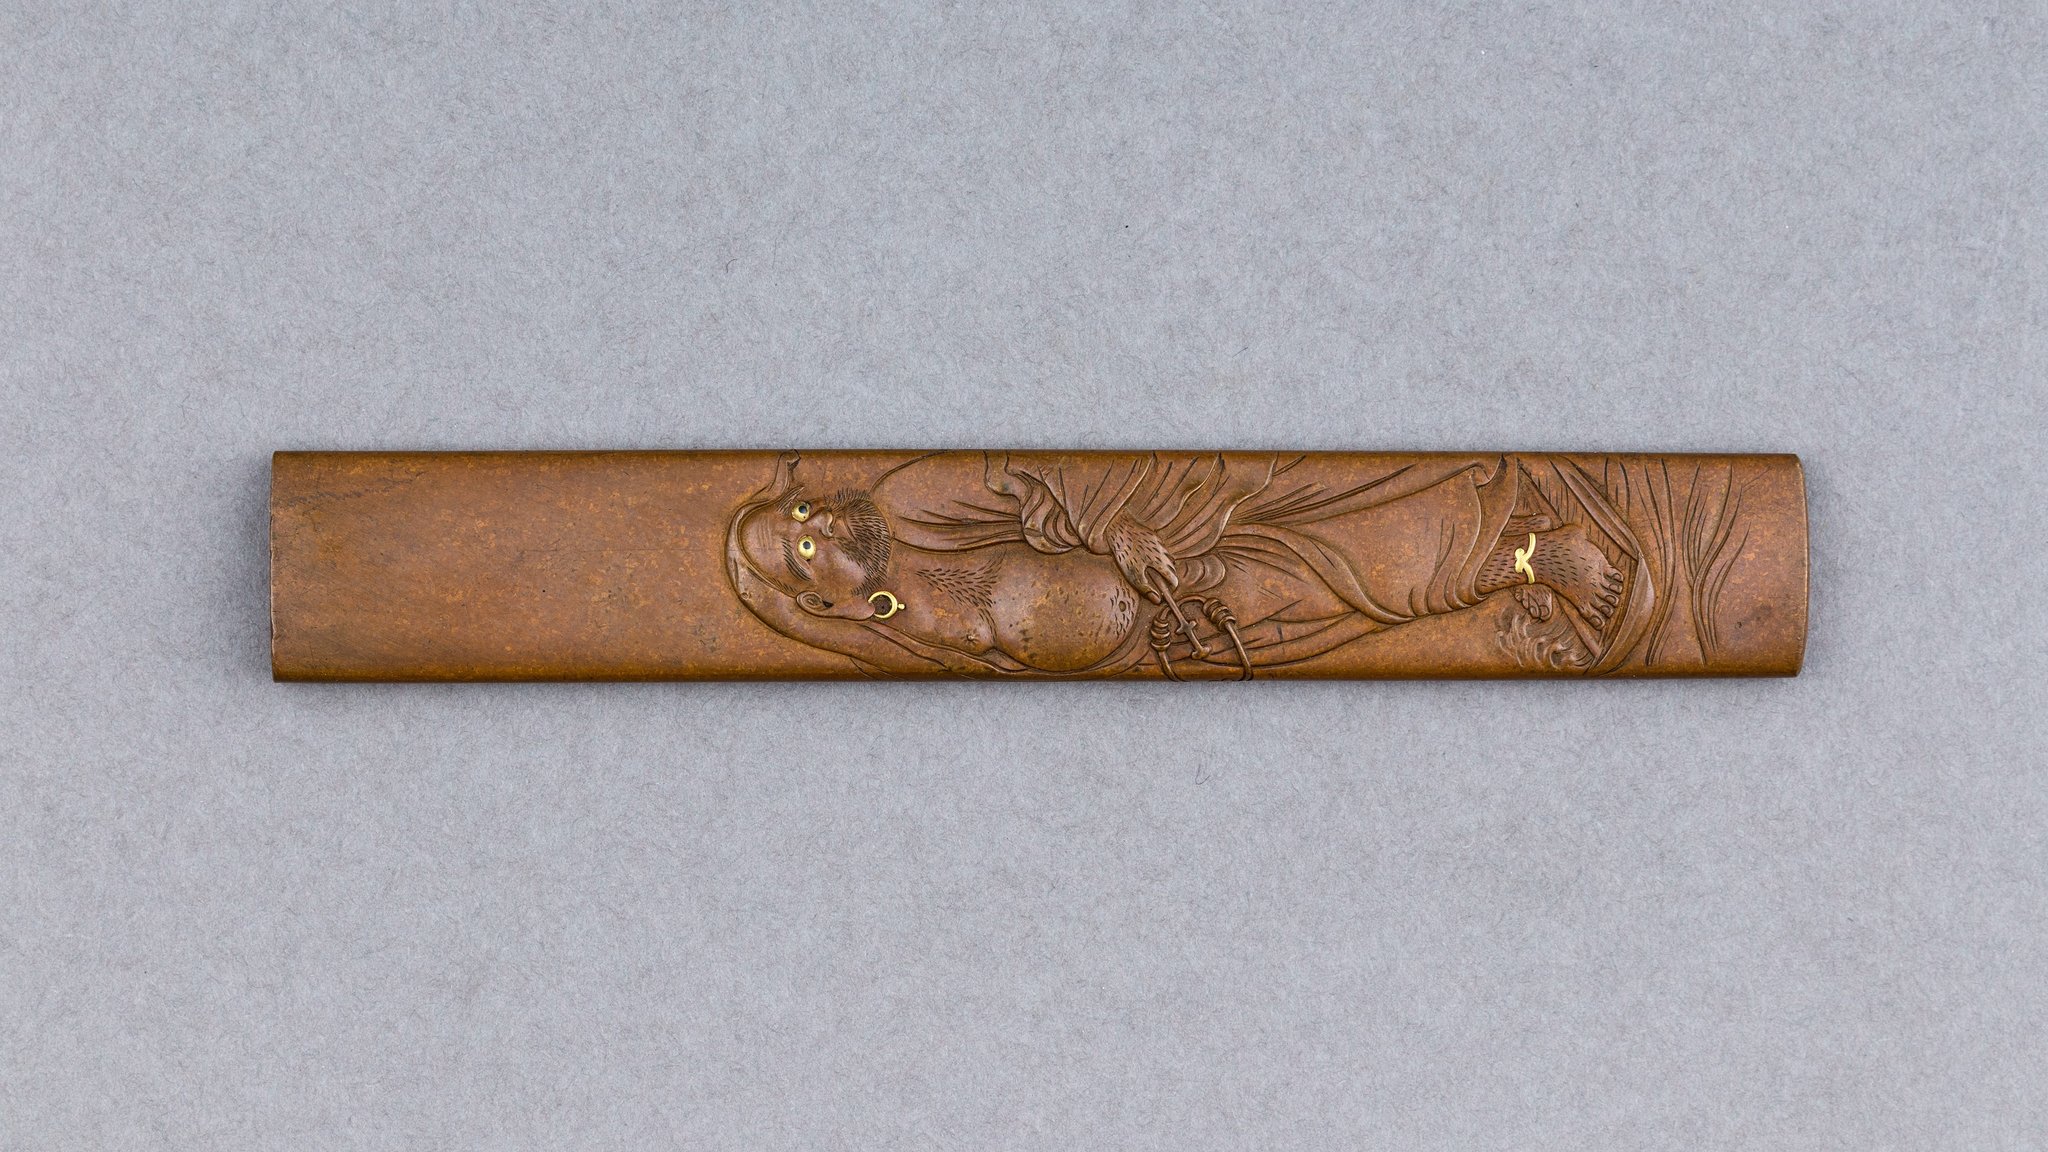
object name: knife handle kozuka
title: Knife Handle (Kozuka)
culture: japanese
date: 1801-1900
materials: copper, gold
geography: japan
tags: men